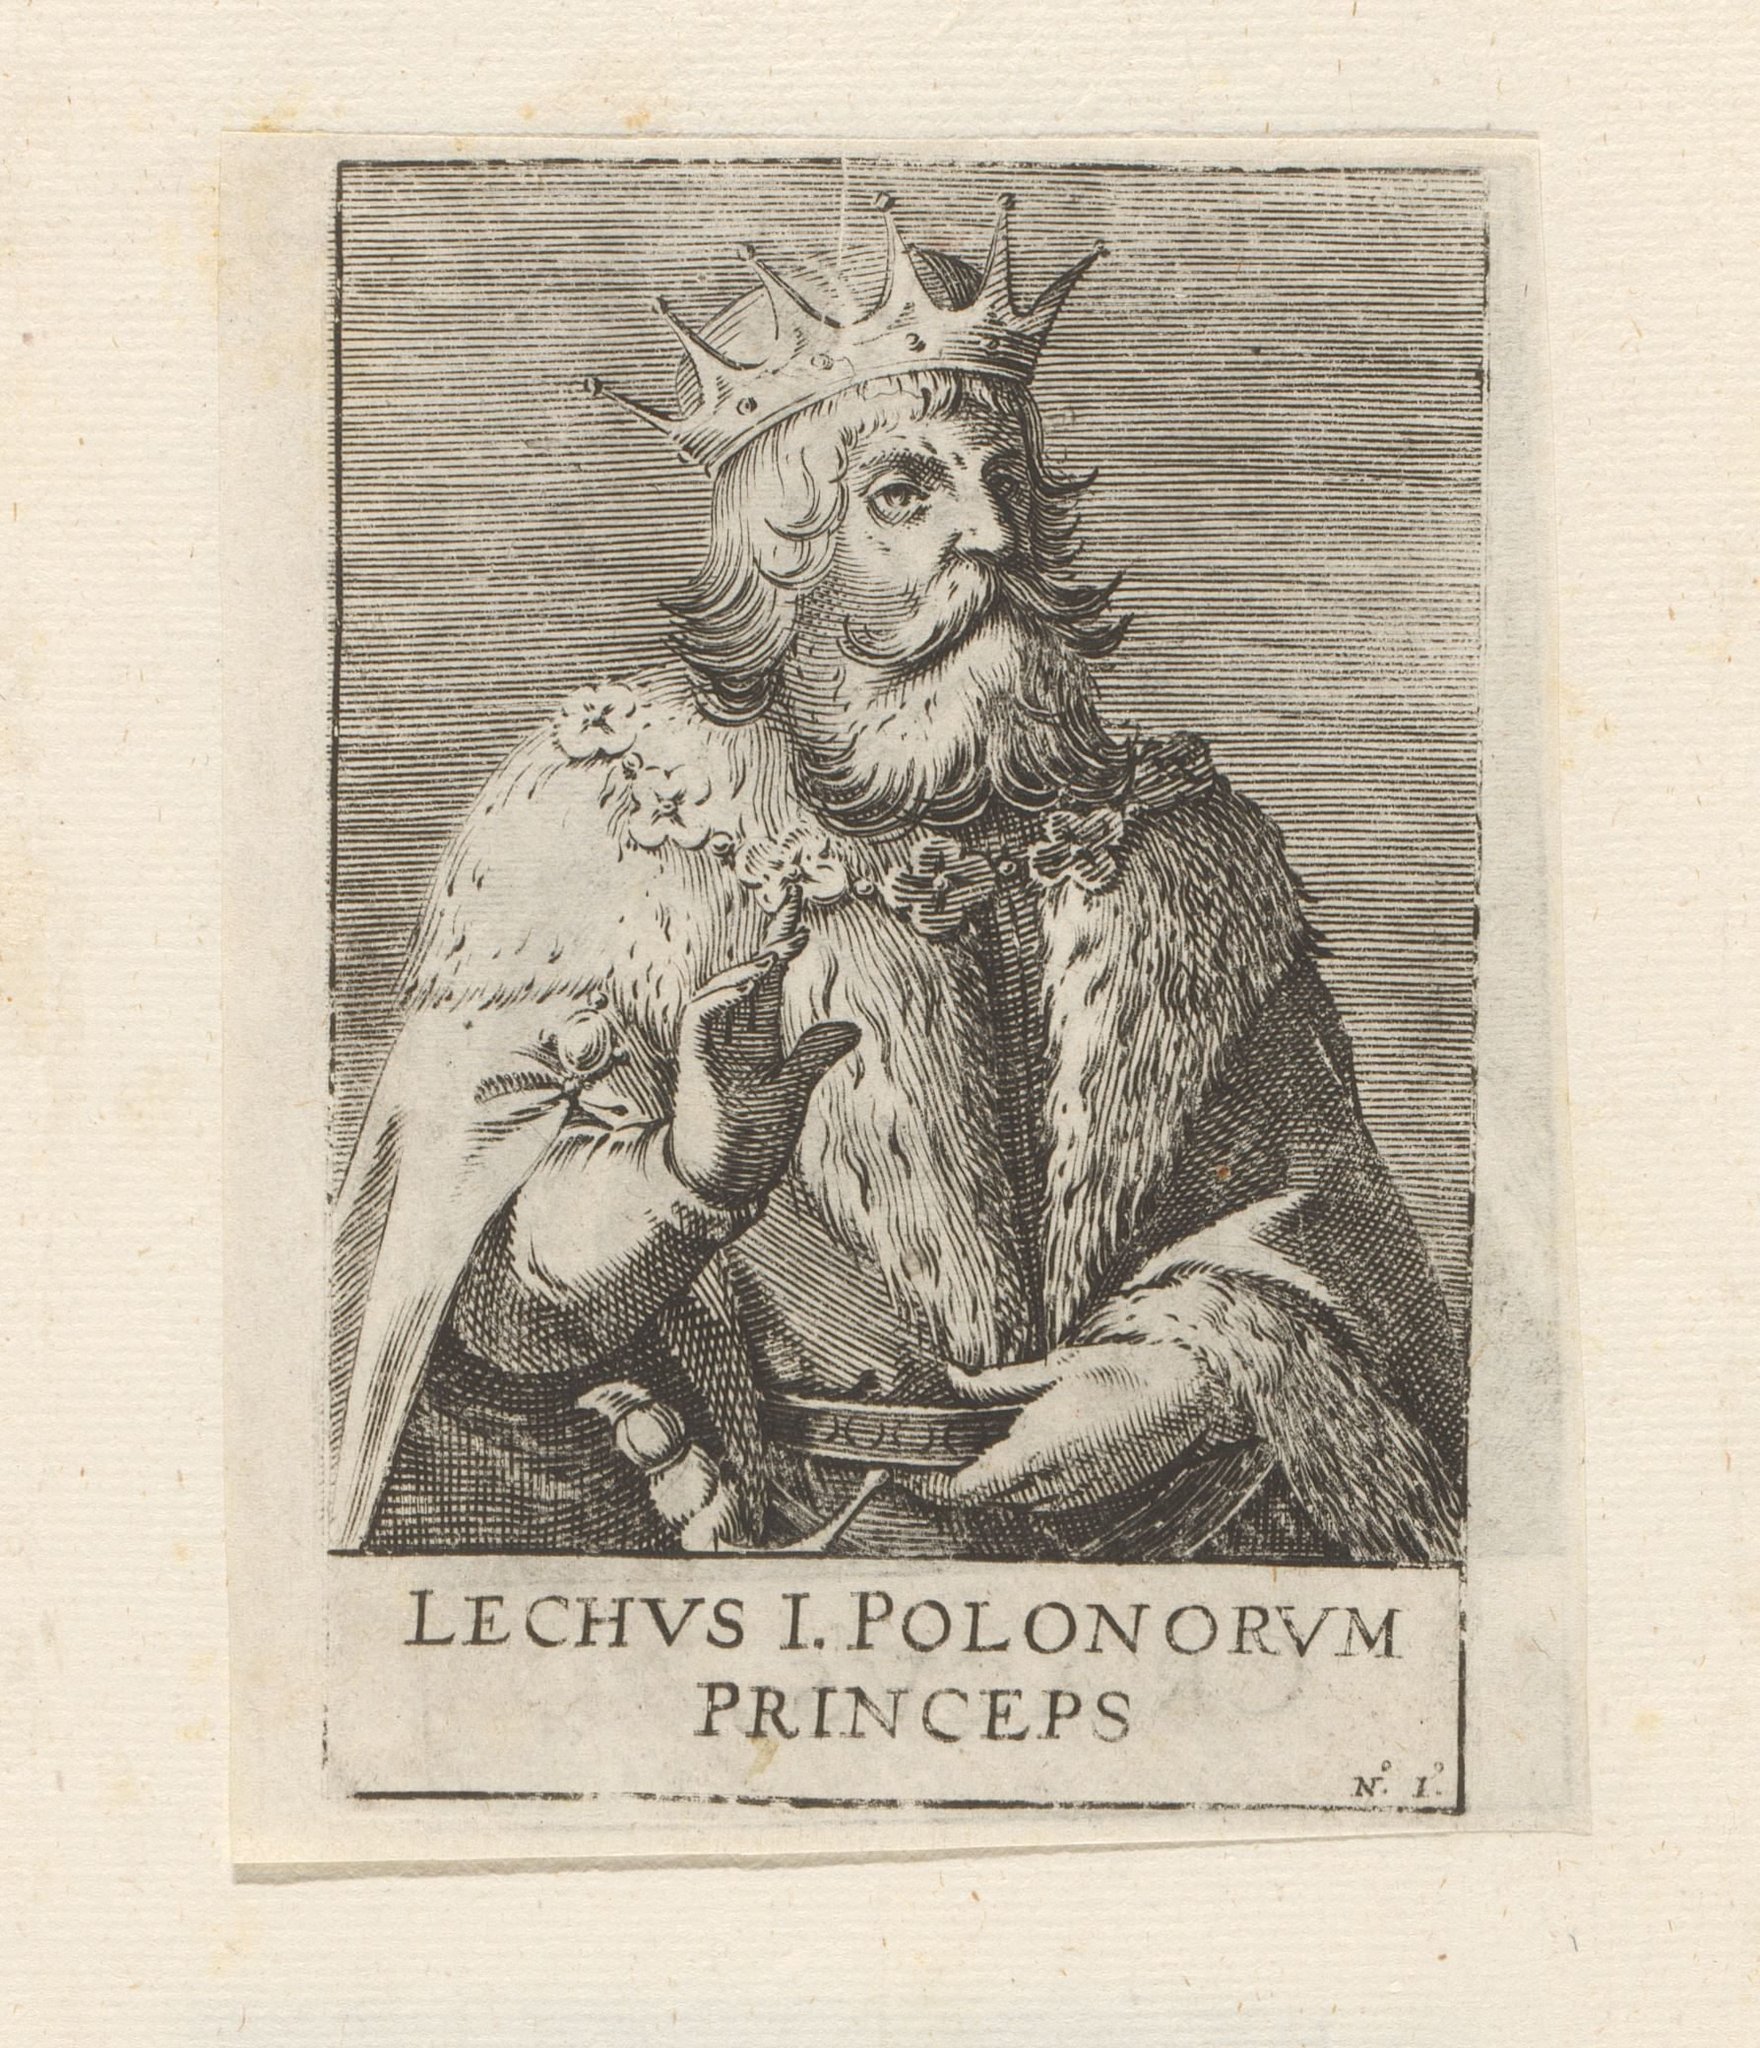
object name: album leaf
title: Portret van Lech I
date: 1574-1594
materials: paper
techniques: woodcut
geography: cologne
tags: historical persons, ruler, sovereign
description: Prent gebruikt in: Mylius, Arnold. Principum et Regum Polonorum Imagines ad Vivum Expressae (...). Keulen: Gottfried von Kempen, 1594.